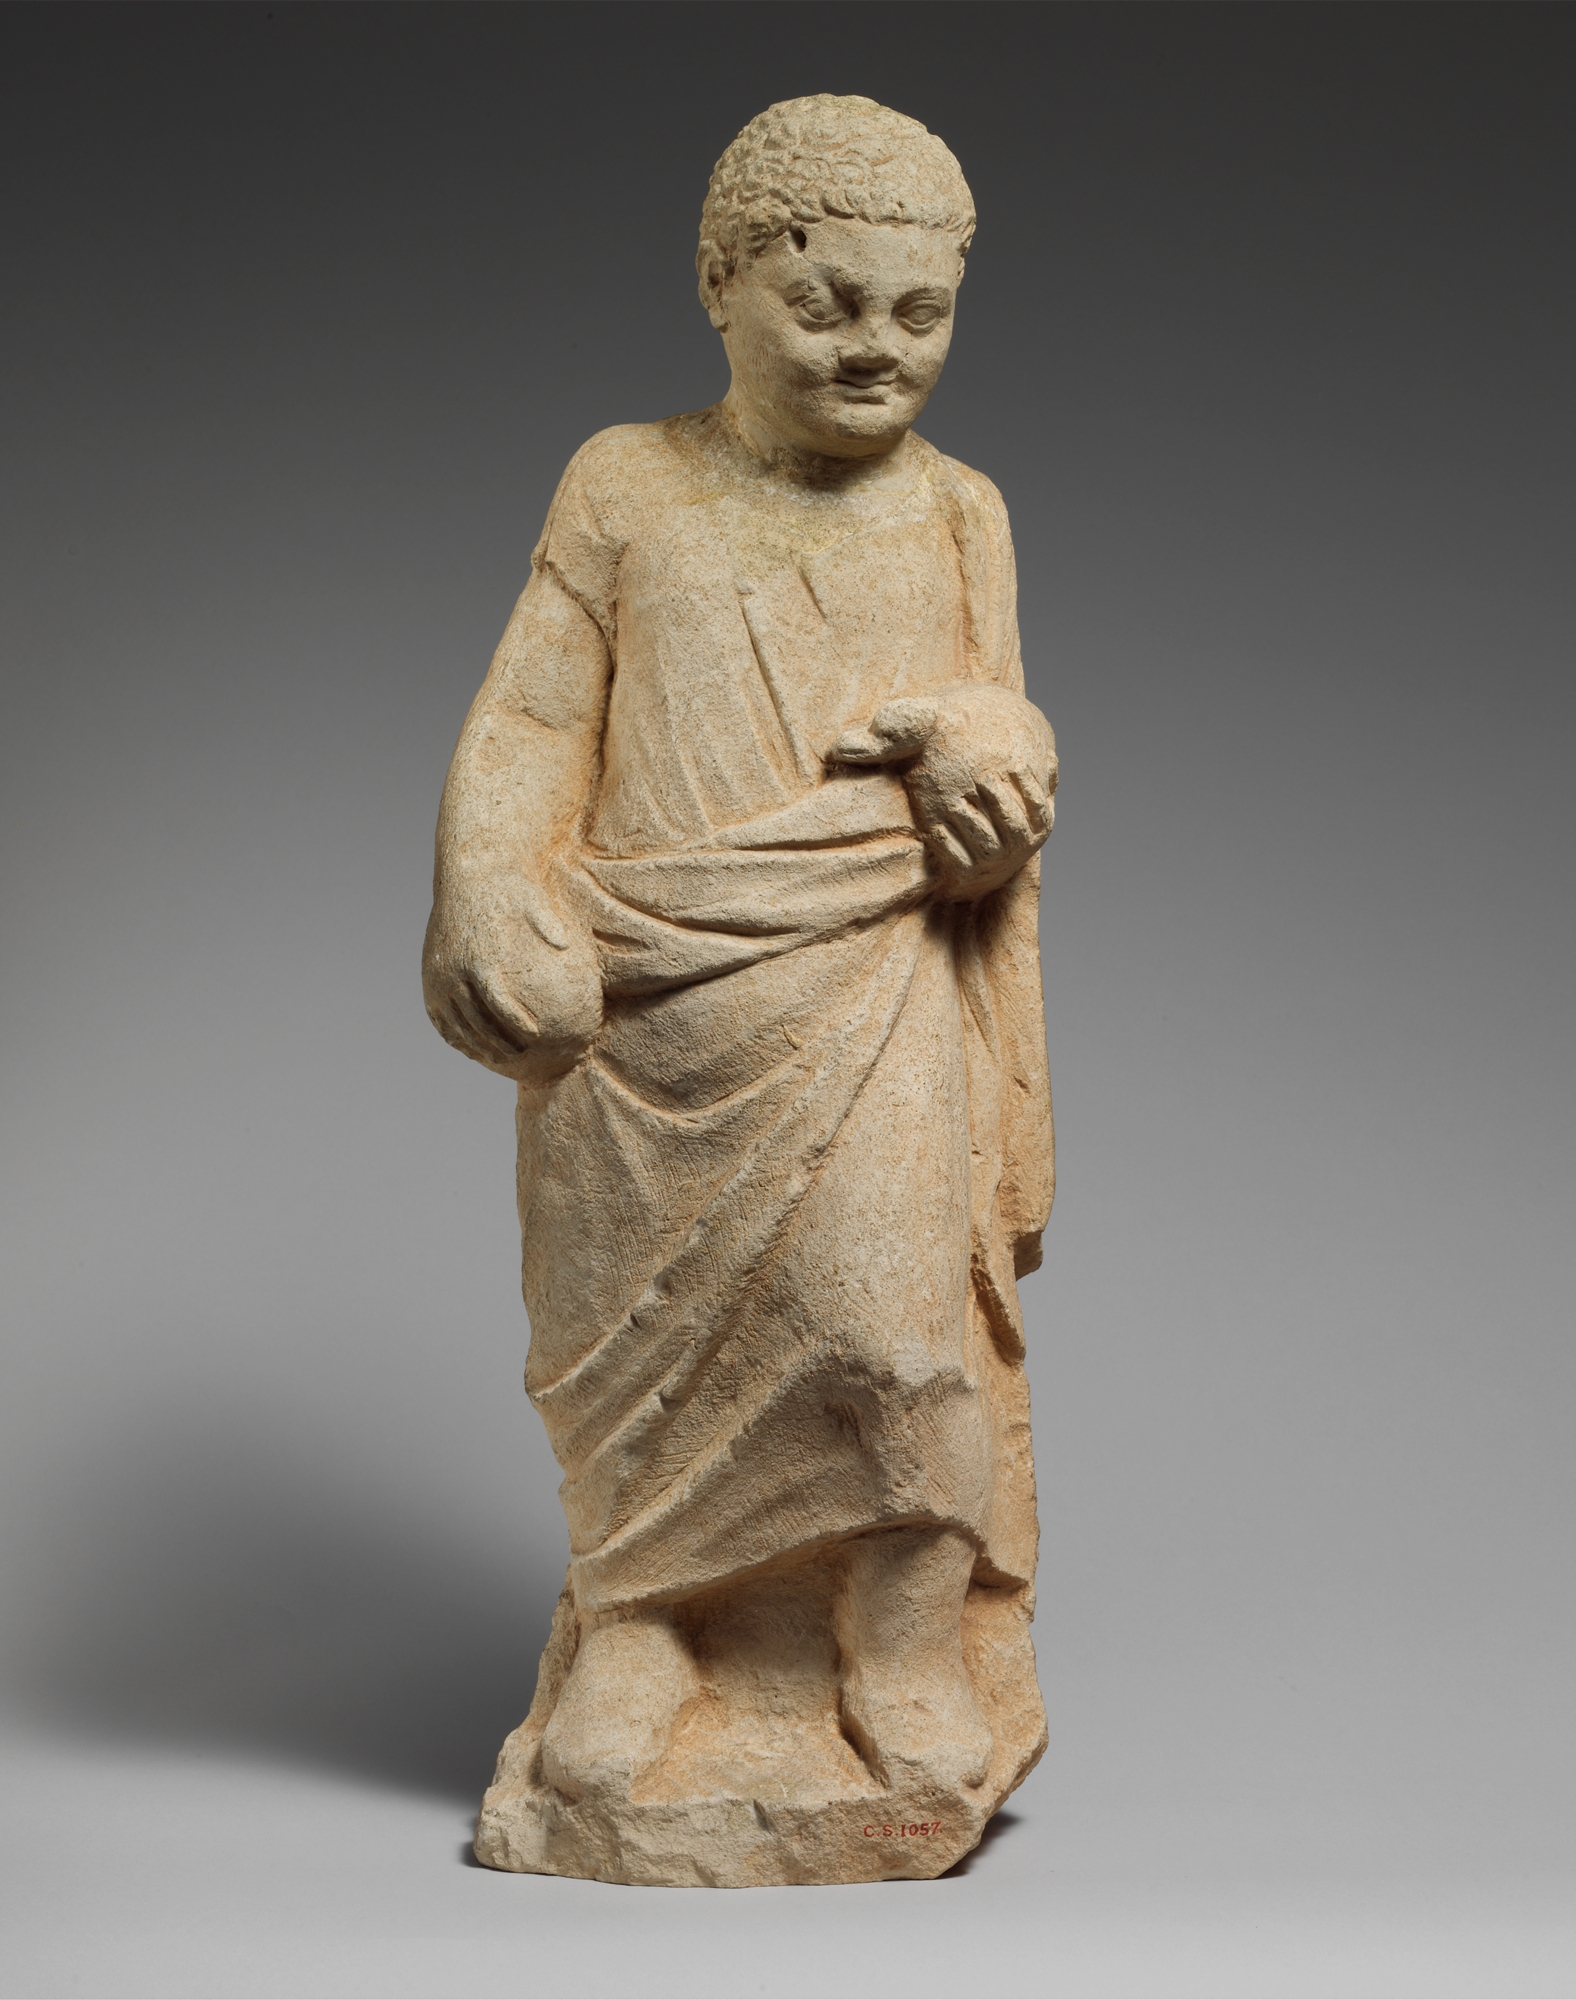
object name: statue of a votary, male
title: Limestone statuette of a boy holding a duck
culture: cypriot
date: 334-201 BCE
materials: limestone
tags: ducks,boys